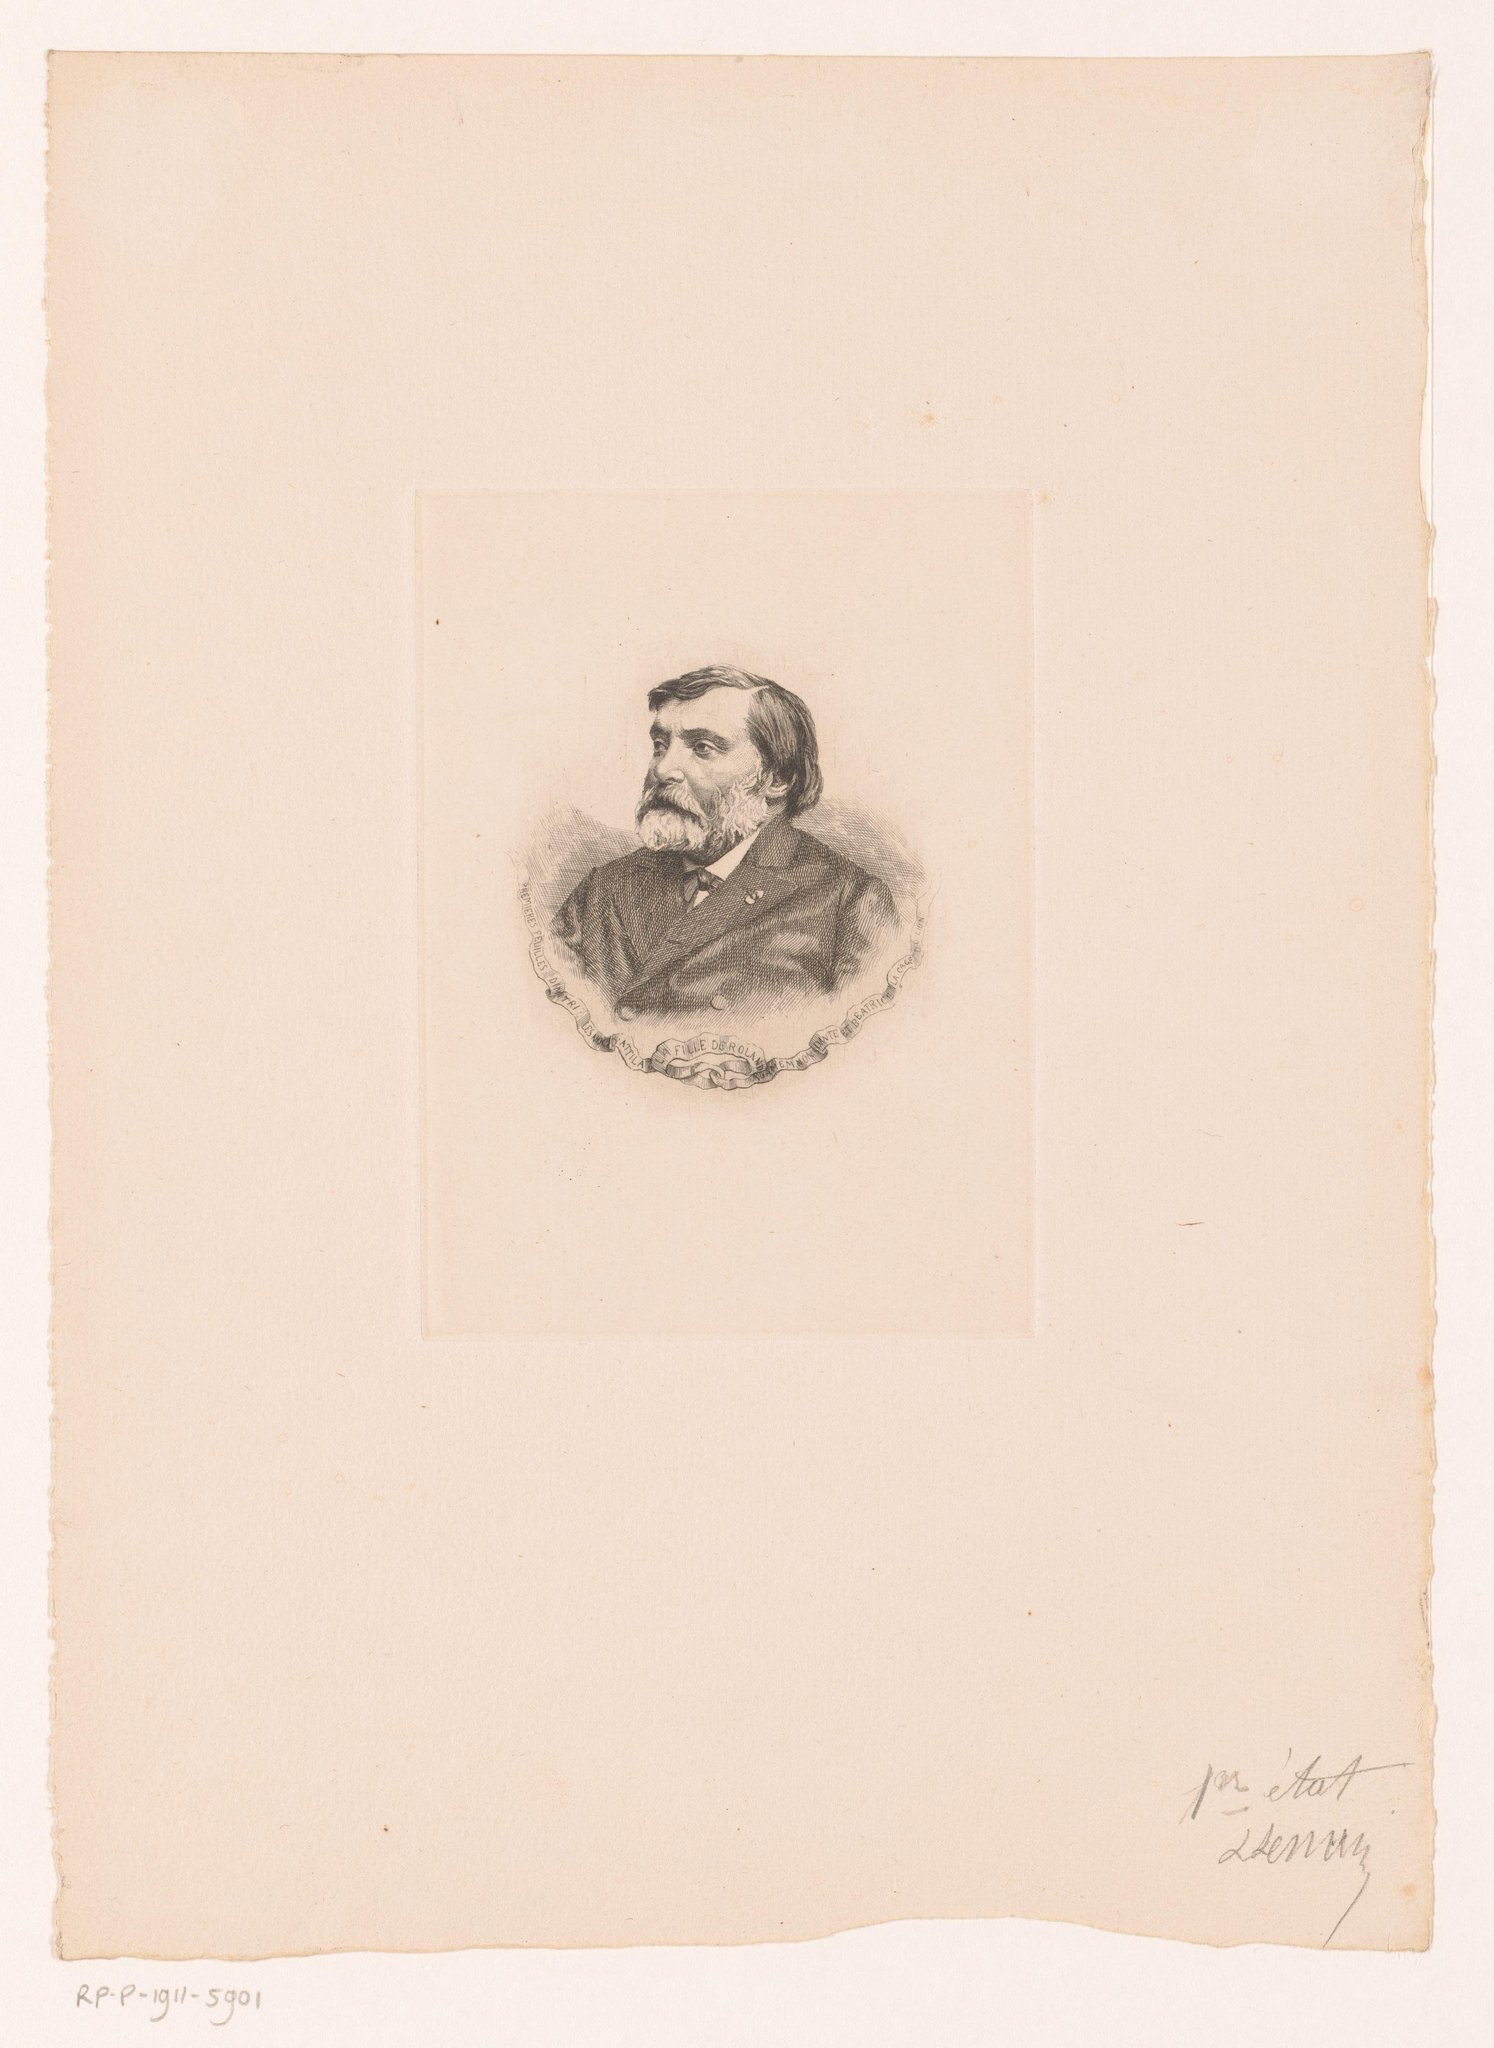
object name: print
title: Portret van Henri de Bornier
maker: louis le nain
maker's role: print maker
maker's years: 1851-1939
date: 1861-1911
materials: paper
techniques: etching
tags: paris, historical persons, beard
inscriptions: collector's mark: Lugt 2228, inscription: ‘1er état LLenain’